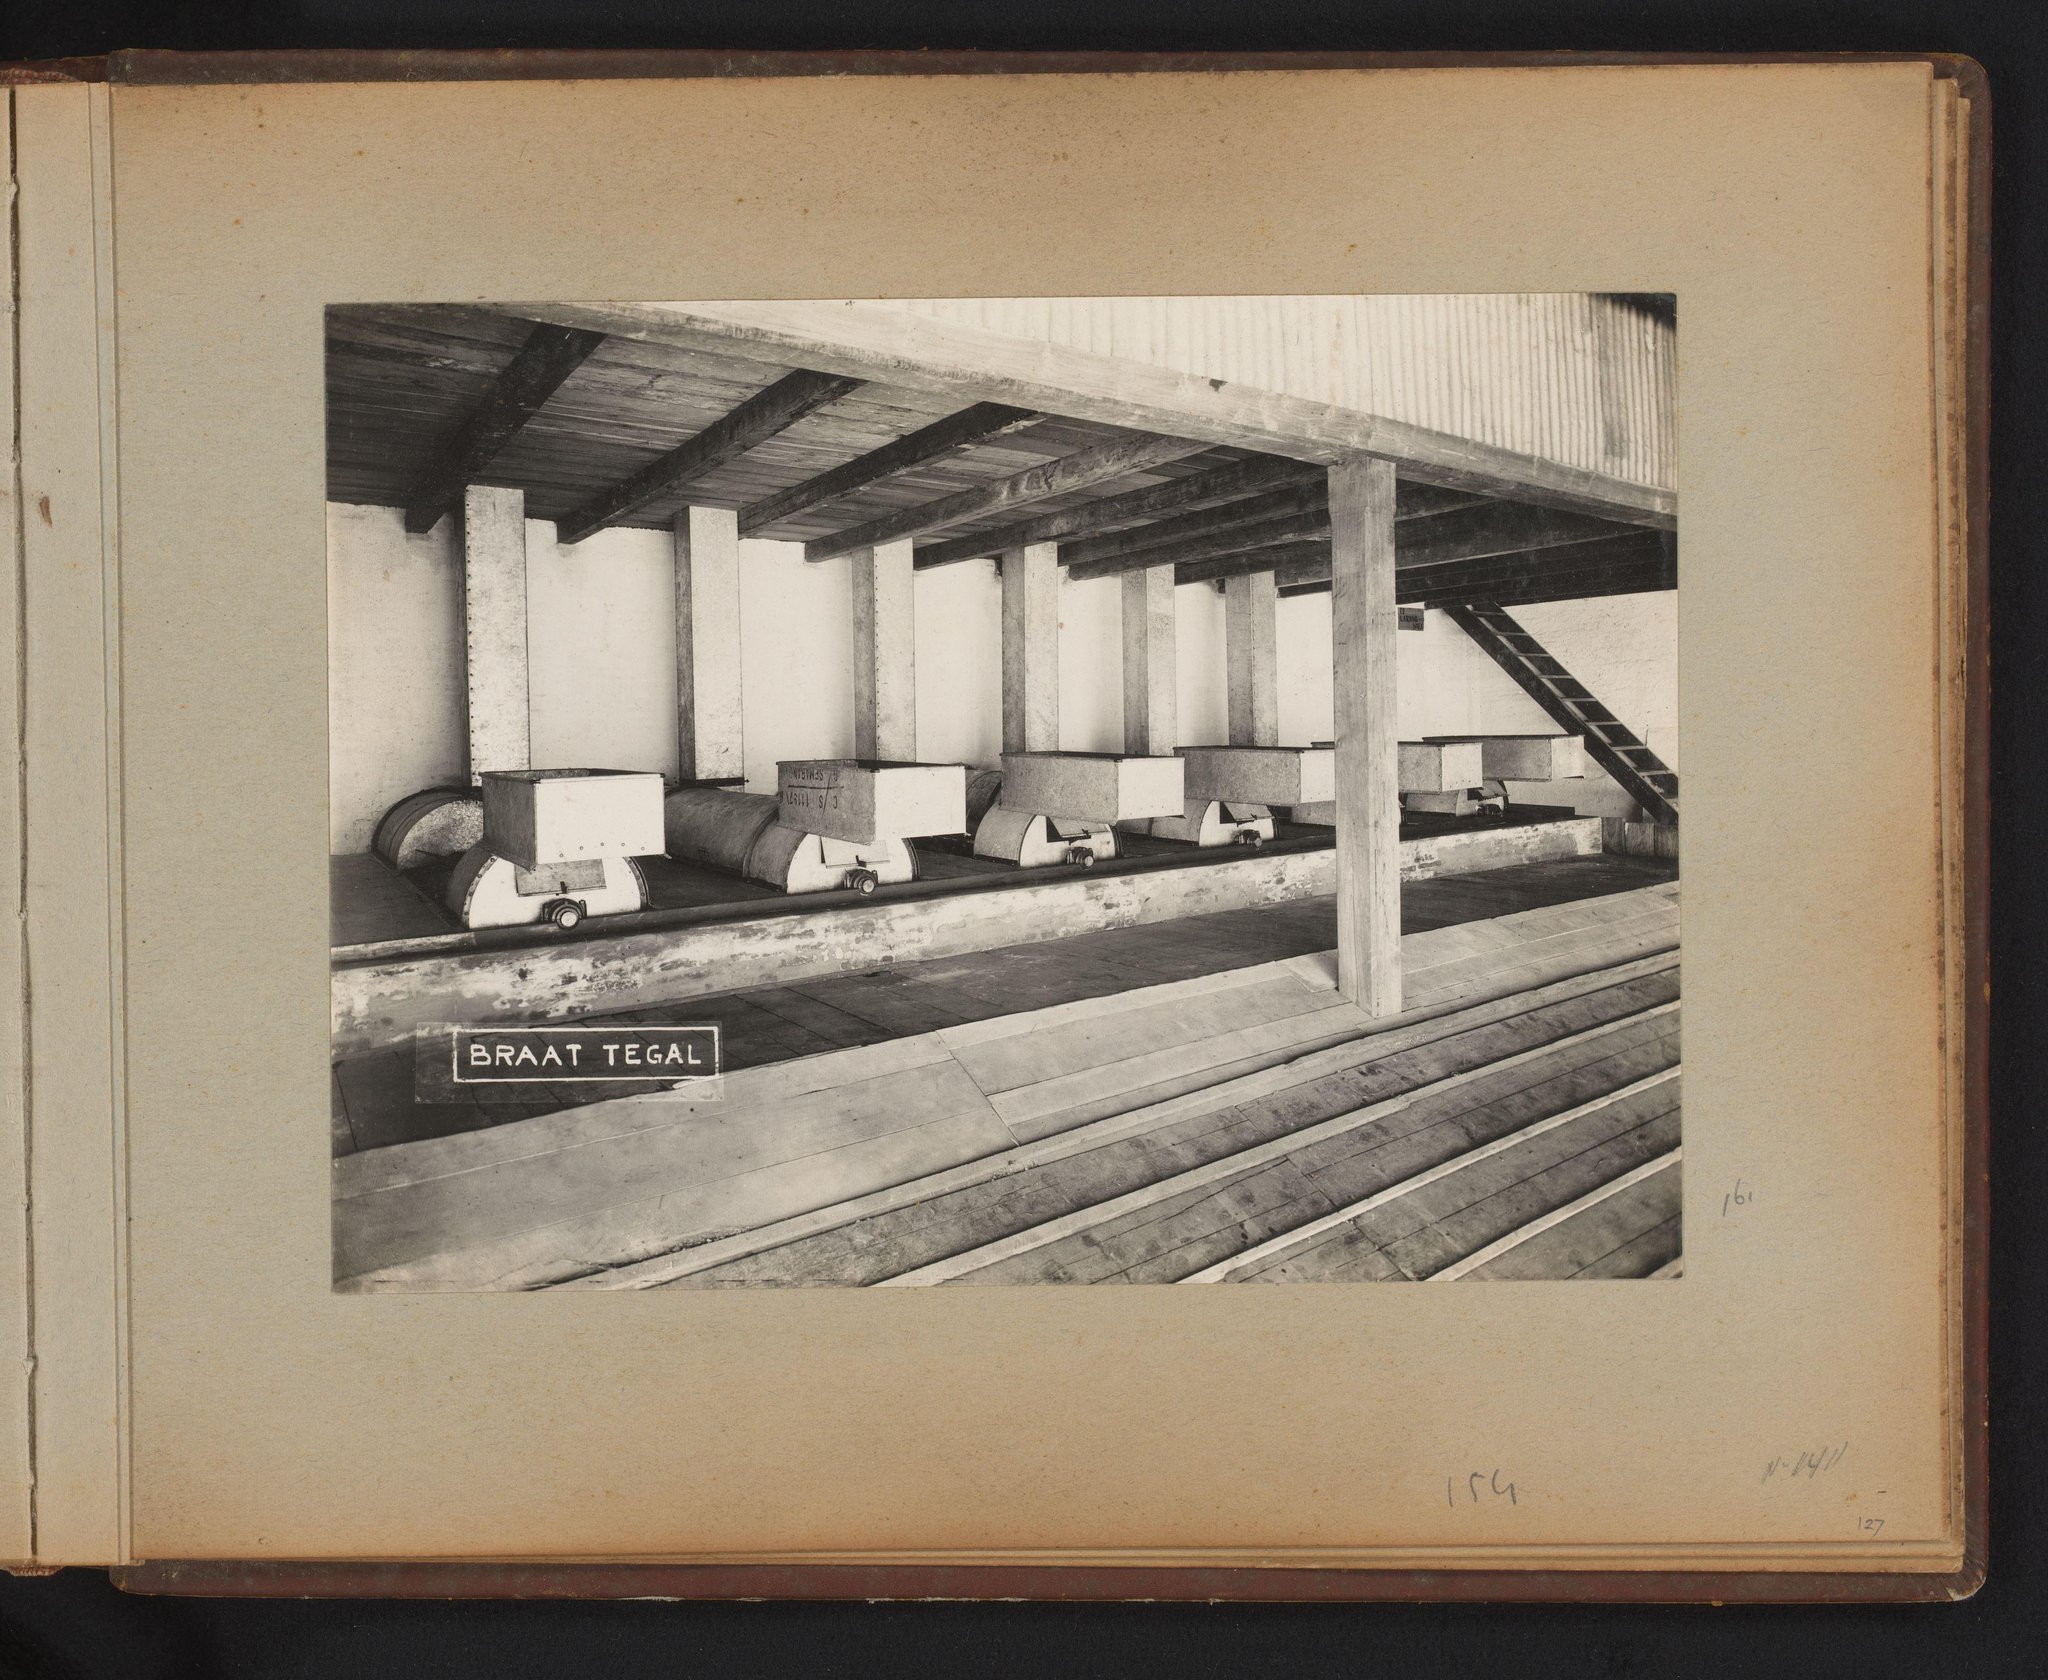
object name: album leaf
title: Installatie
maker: Anonymous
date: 1931-1937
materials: cardboard, photographic support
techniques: gelatin silver print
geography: tegal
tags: factory-interior, machine shop, machines; parts of machines; tools and appliances, java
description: Albumblad met een foto van een installatie ingericht door Braat Tegal. Onderdeel van een fotoalbum met foto's van machines en constructies van de N.V. Machinefabriek Braat te Soerabaja, Soekaboemi en Tegal uit de periode 1931-1937.